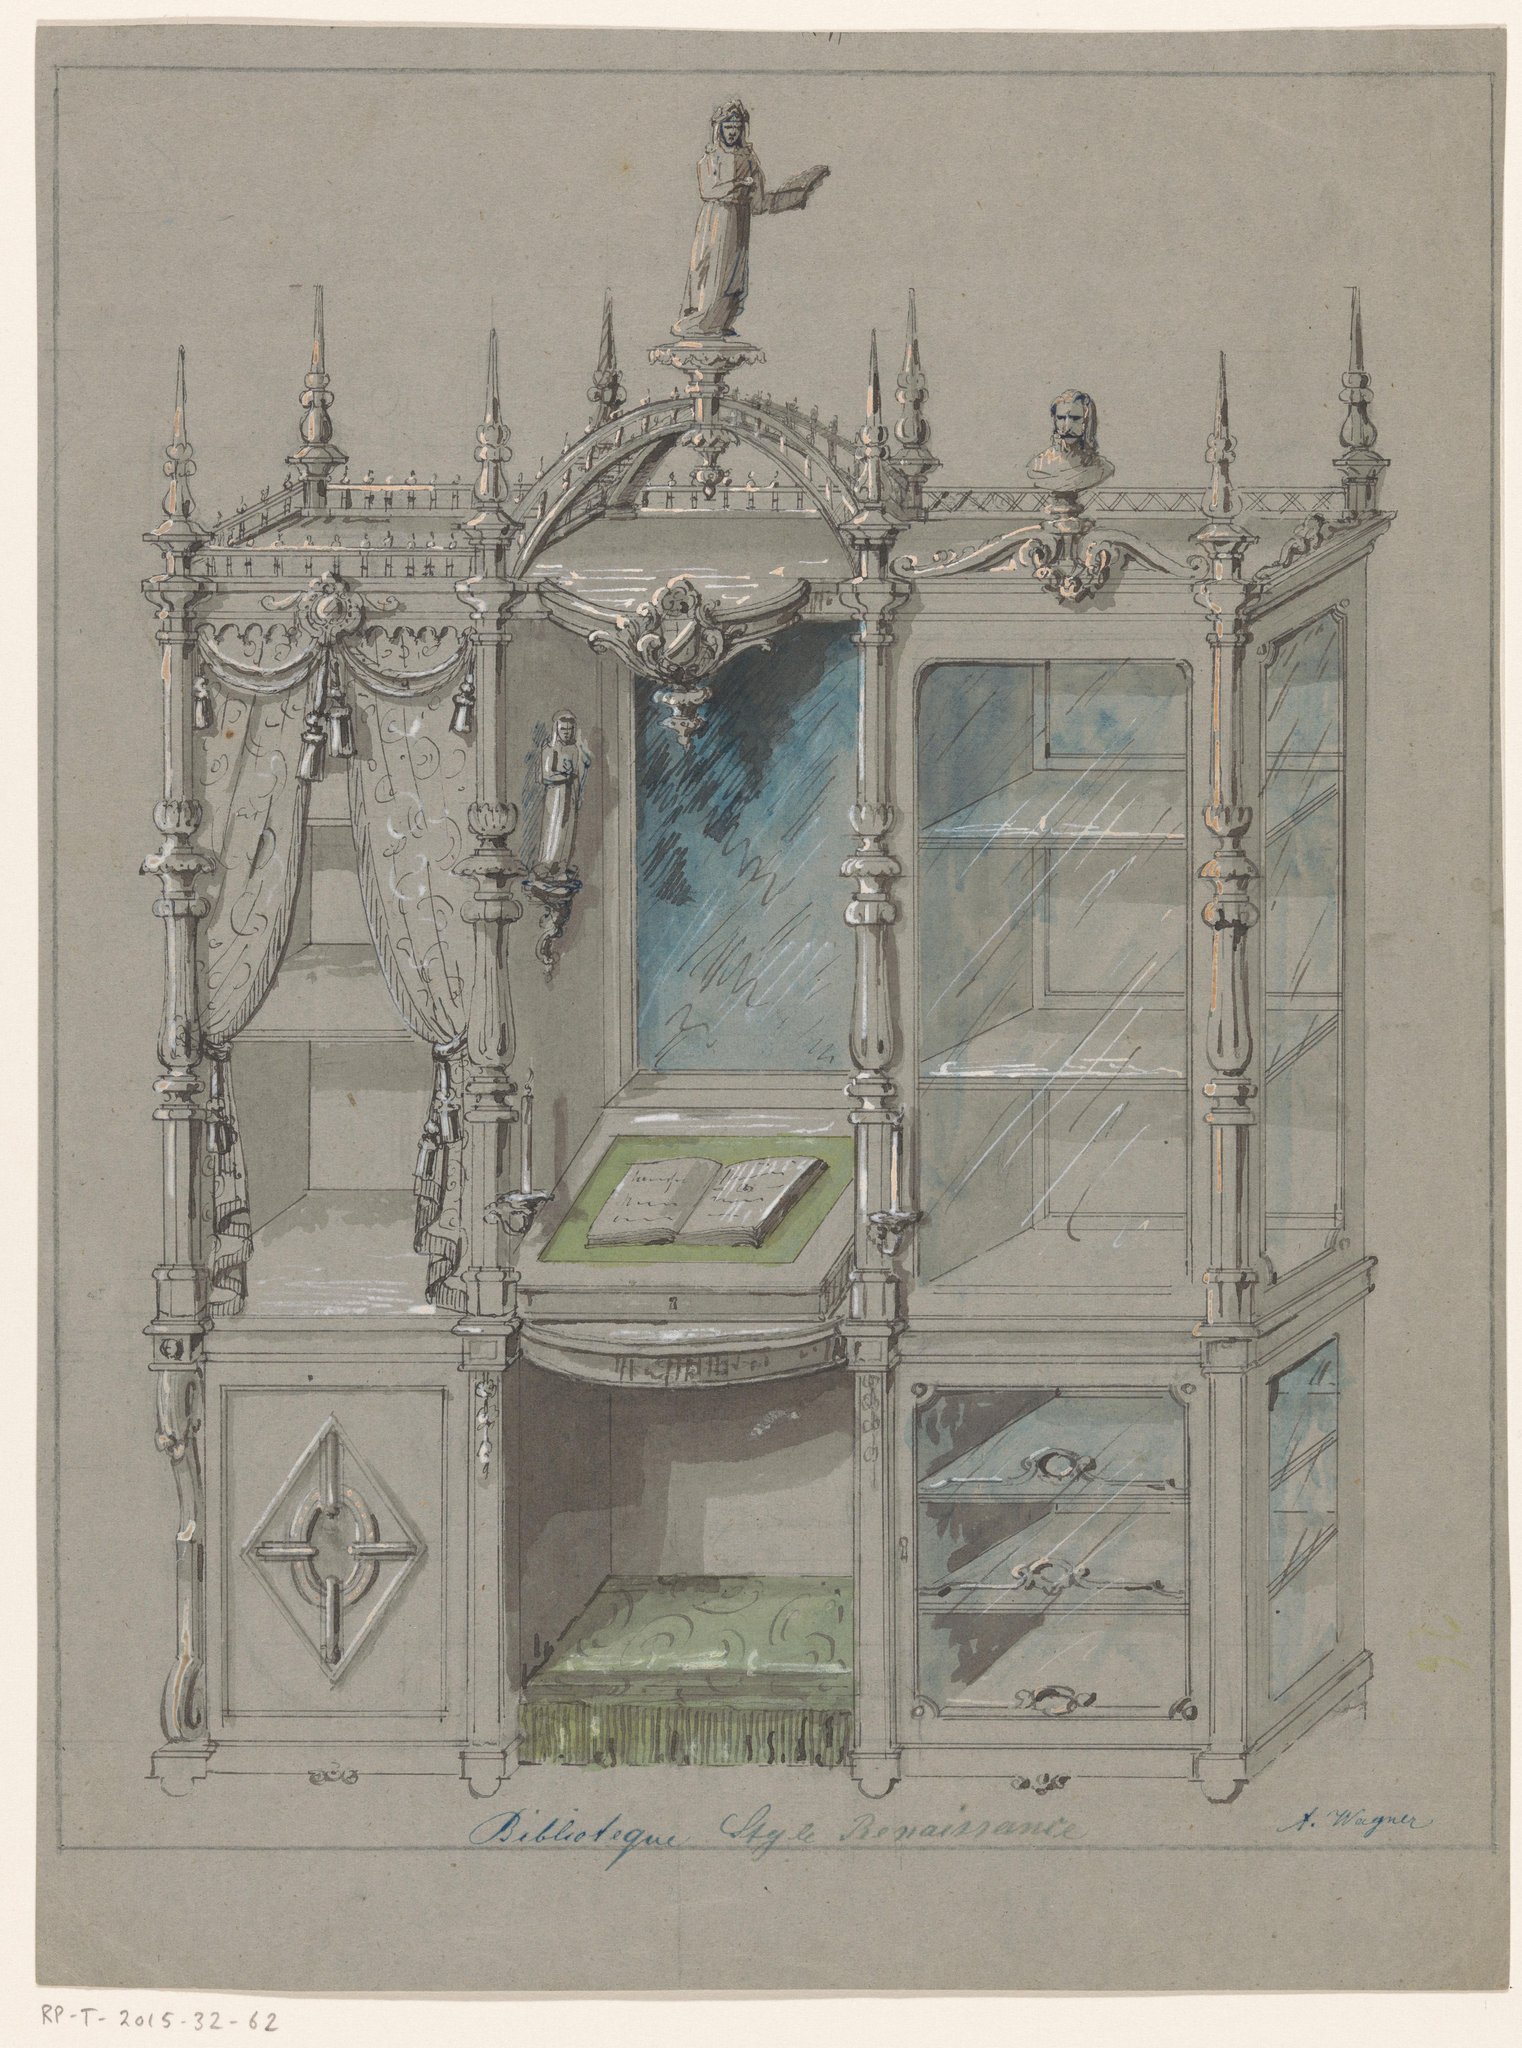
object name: drawing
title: Boekenkast in neorenaissancistische stijl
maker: adolf wagner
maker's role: draughtsman, painter, sculptor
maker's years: 1884-1962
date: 1900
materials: paint, ink, paper, watercolor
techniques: brush, pen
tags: bookshelves, furniture for storage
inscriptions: inscription: ‘Biblioteque Style Renaissance A. Wagner’, collector's mark, collector's mark: Lugt 2228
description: In het midden een lessenaar met een opengeslagen boek onder een spiegel. Aan weerszijden boekenplanken, gedeeltelijk voorzien van glas. Het meubel gedecoreerd met houtsnijwerk en drie houten beeldjes.